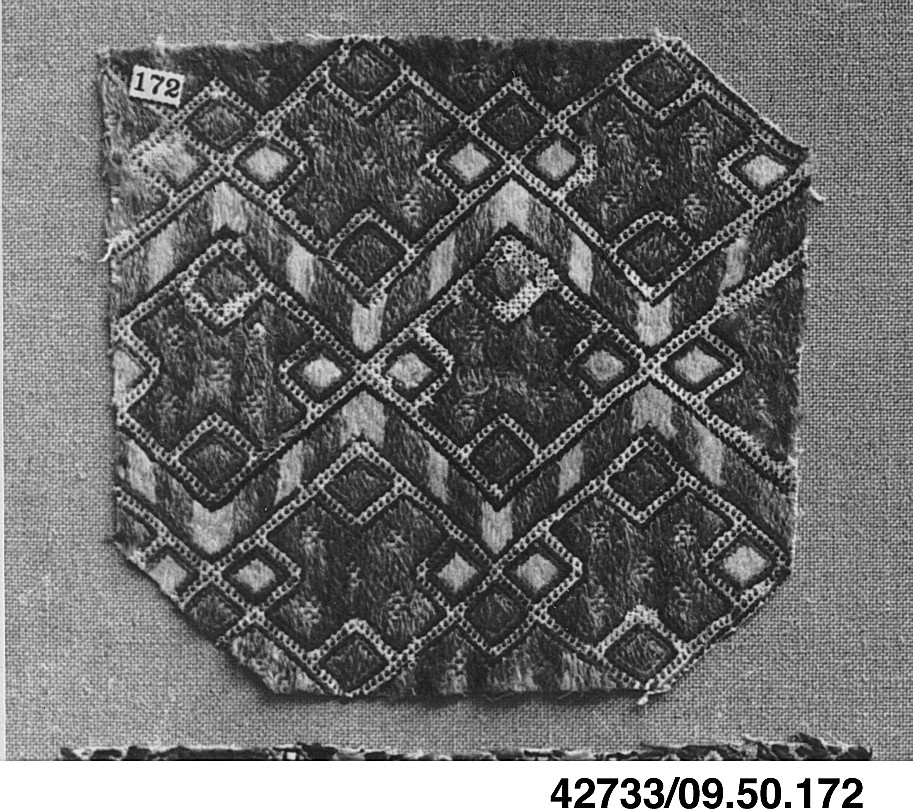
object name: costume fragment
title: Peasant costume fragment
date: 1701-1900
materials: canvas, wool